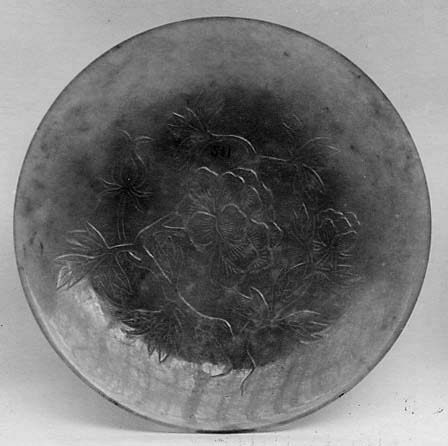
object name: dish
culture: chinese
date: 1736-1795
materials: jade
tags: flowers,leaves